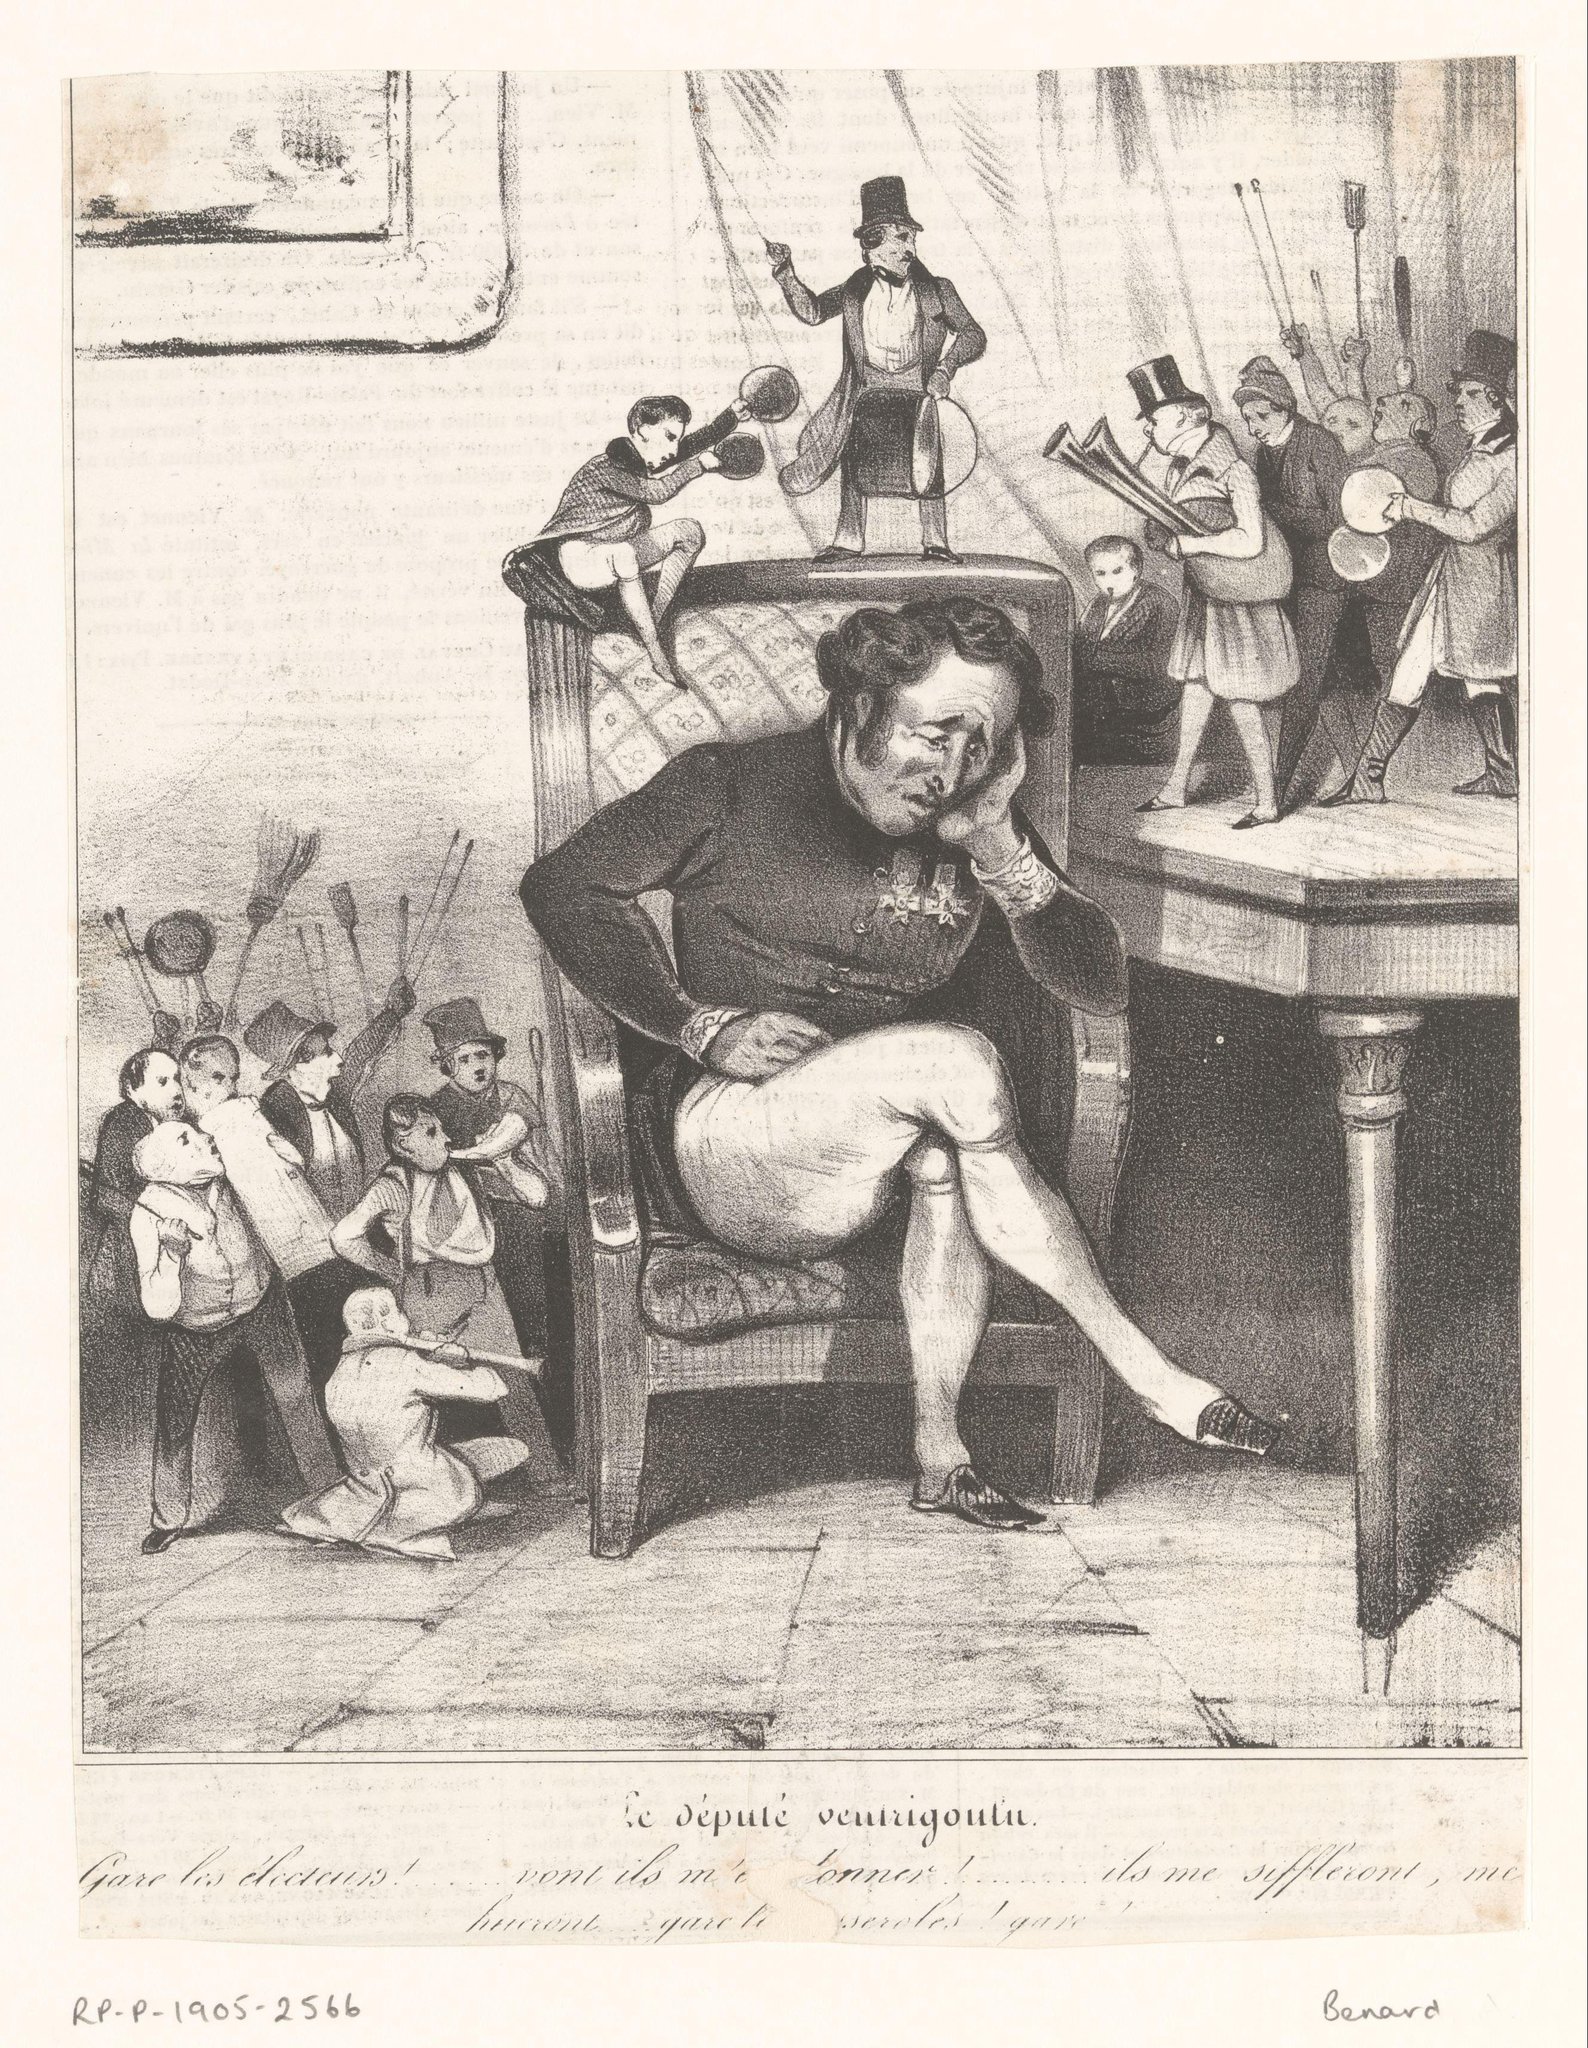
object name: cartoon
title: L'imagination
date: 1833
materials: paper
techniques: lithograph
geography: paris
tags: political demonstration, politician, e.g. party leader, political caricatures and satires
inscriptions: collector's mark: Lugt 2228a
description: De afgevaardigde zit in een stoel, terwijl de kiezers in een demonstratie om hem heen staan met trommels, blaasinstrumenten en bezems. Hij zou ze het liefst vermijden, want hij voorspelt dat ze hem zullen wegfluiten.